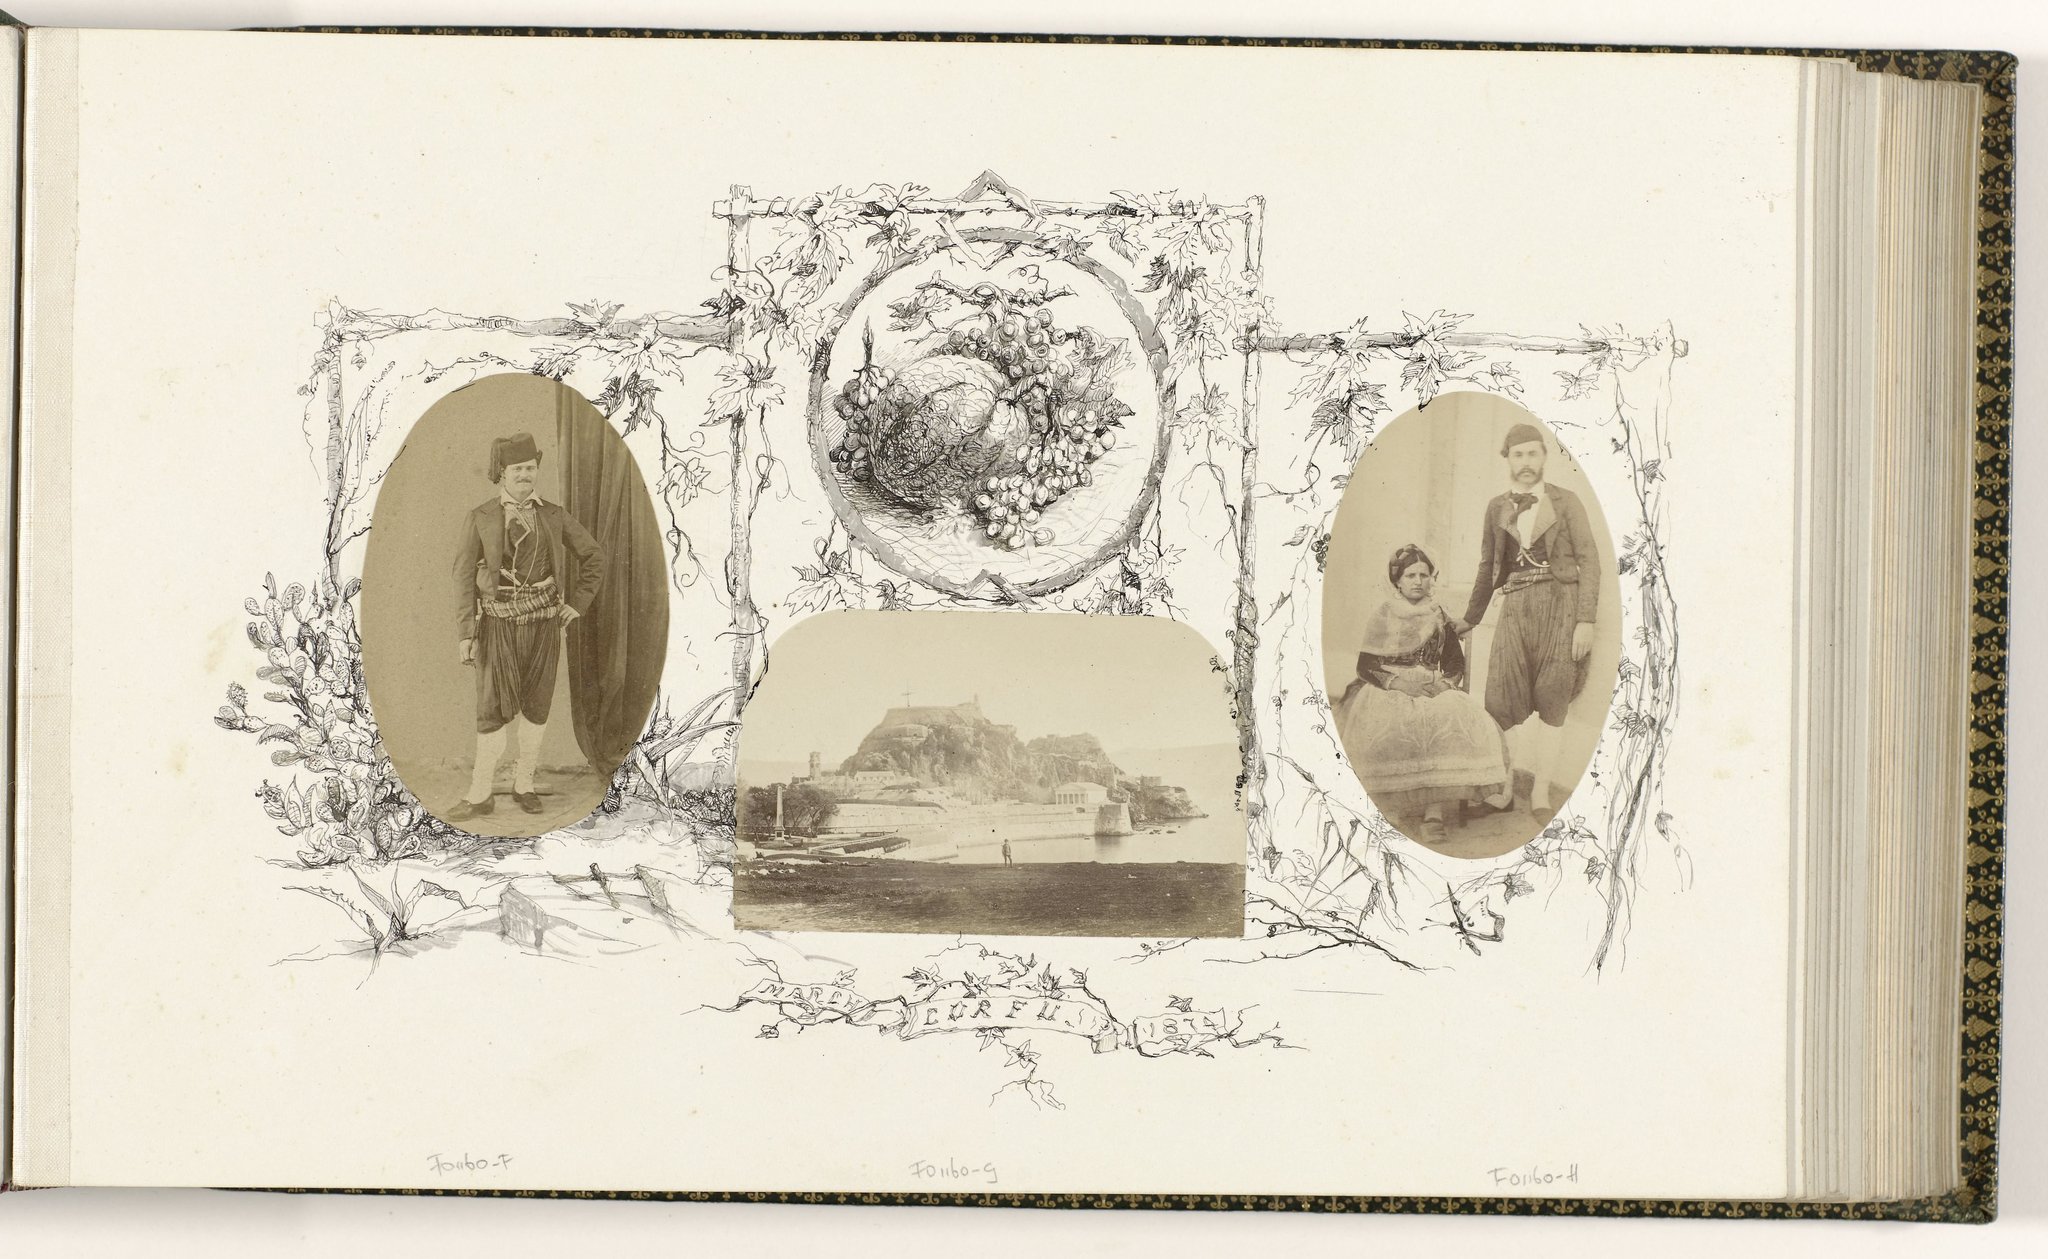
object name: album leaf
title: Portret van een onbekende man en vrouw in klederdracht, mogelijk op Korfoe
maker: Anonymous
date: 1870-1875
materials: paper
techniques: albumen print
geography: corfu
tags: adult woman, adult man, historical persons